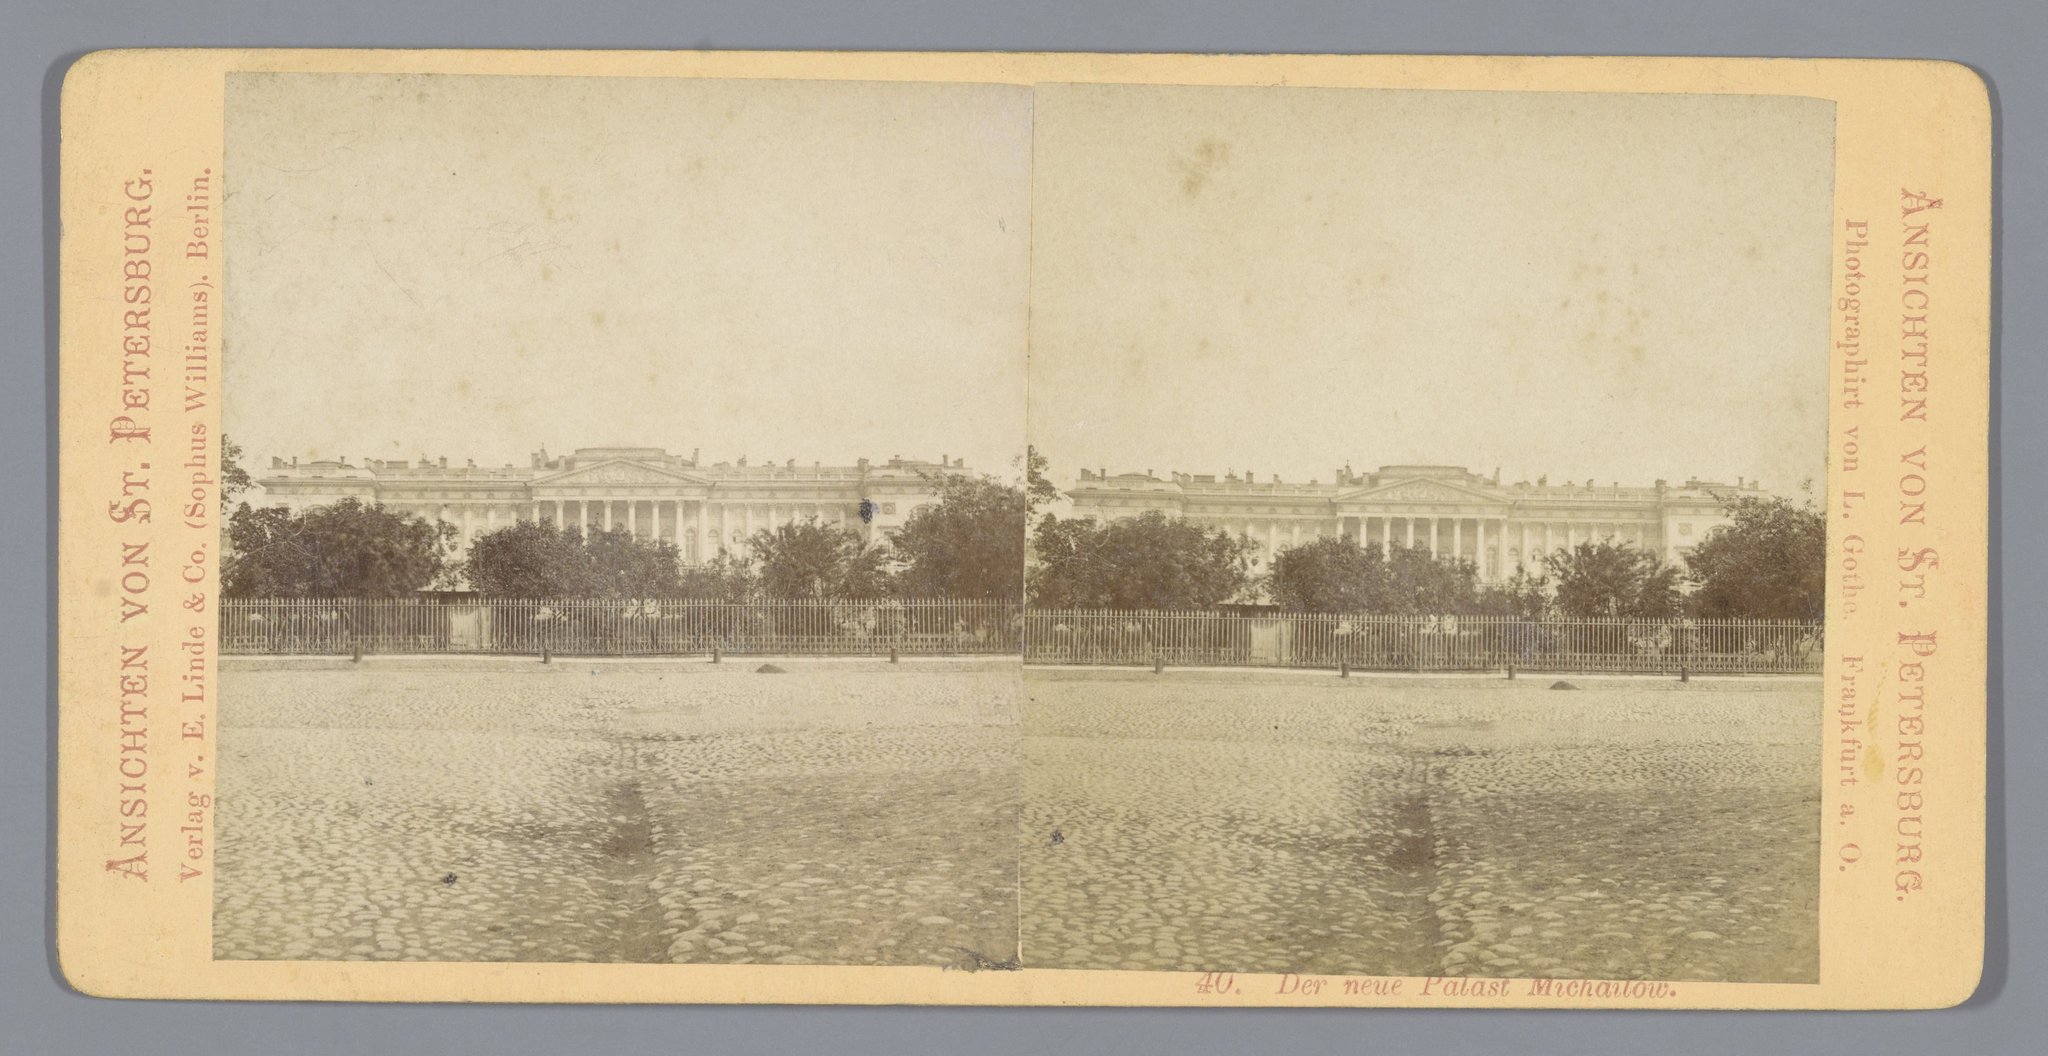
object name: stereograph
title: Der neue Palast Michailow.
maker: louis gothe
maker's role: fotograaf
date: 1850-1880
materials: cardboard, photographic support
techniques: albumen print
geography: berlin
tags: palace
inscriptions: inscription: ‘Ansichten von St. Petersburg.’, number: ‘40.’